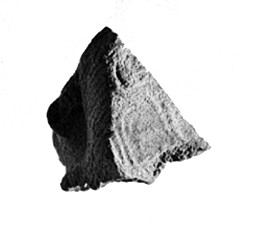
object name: sealing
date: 1981-1640 BCE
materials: mud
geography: egypt